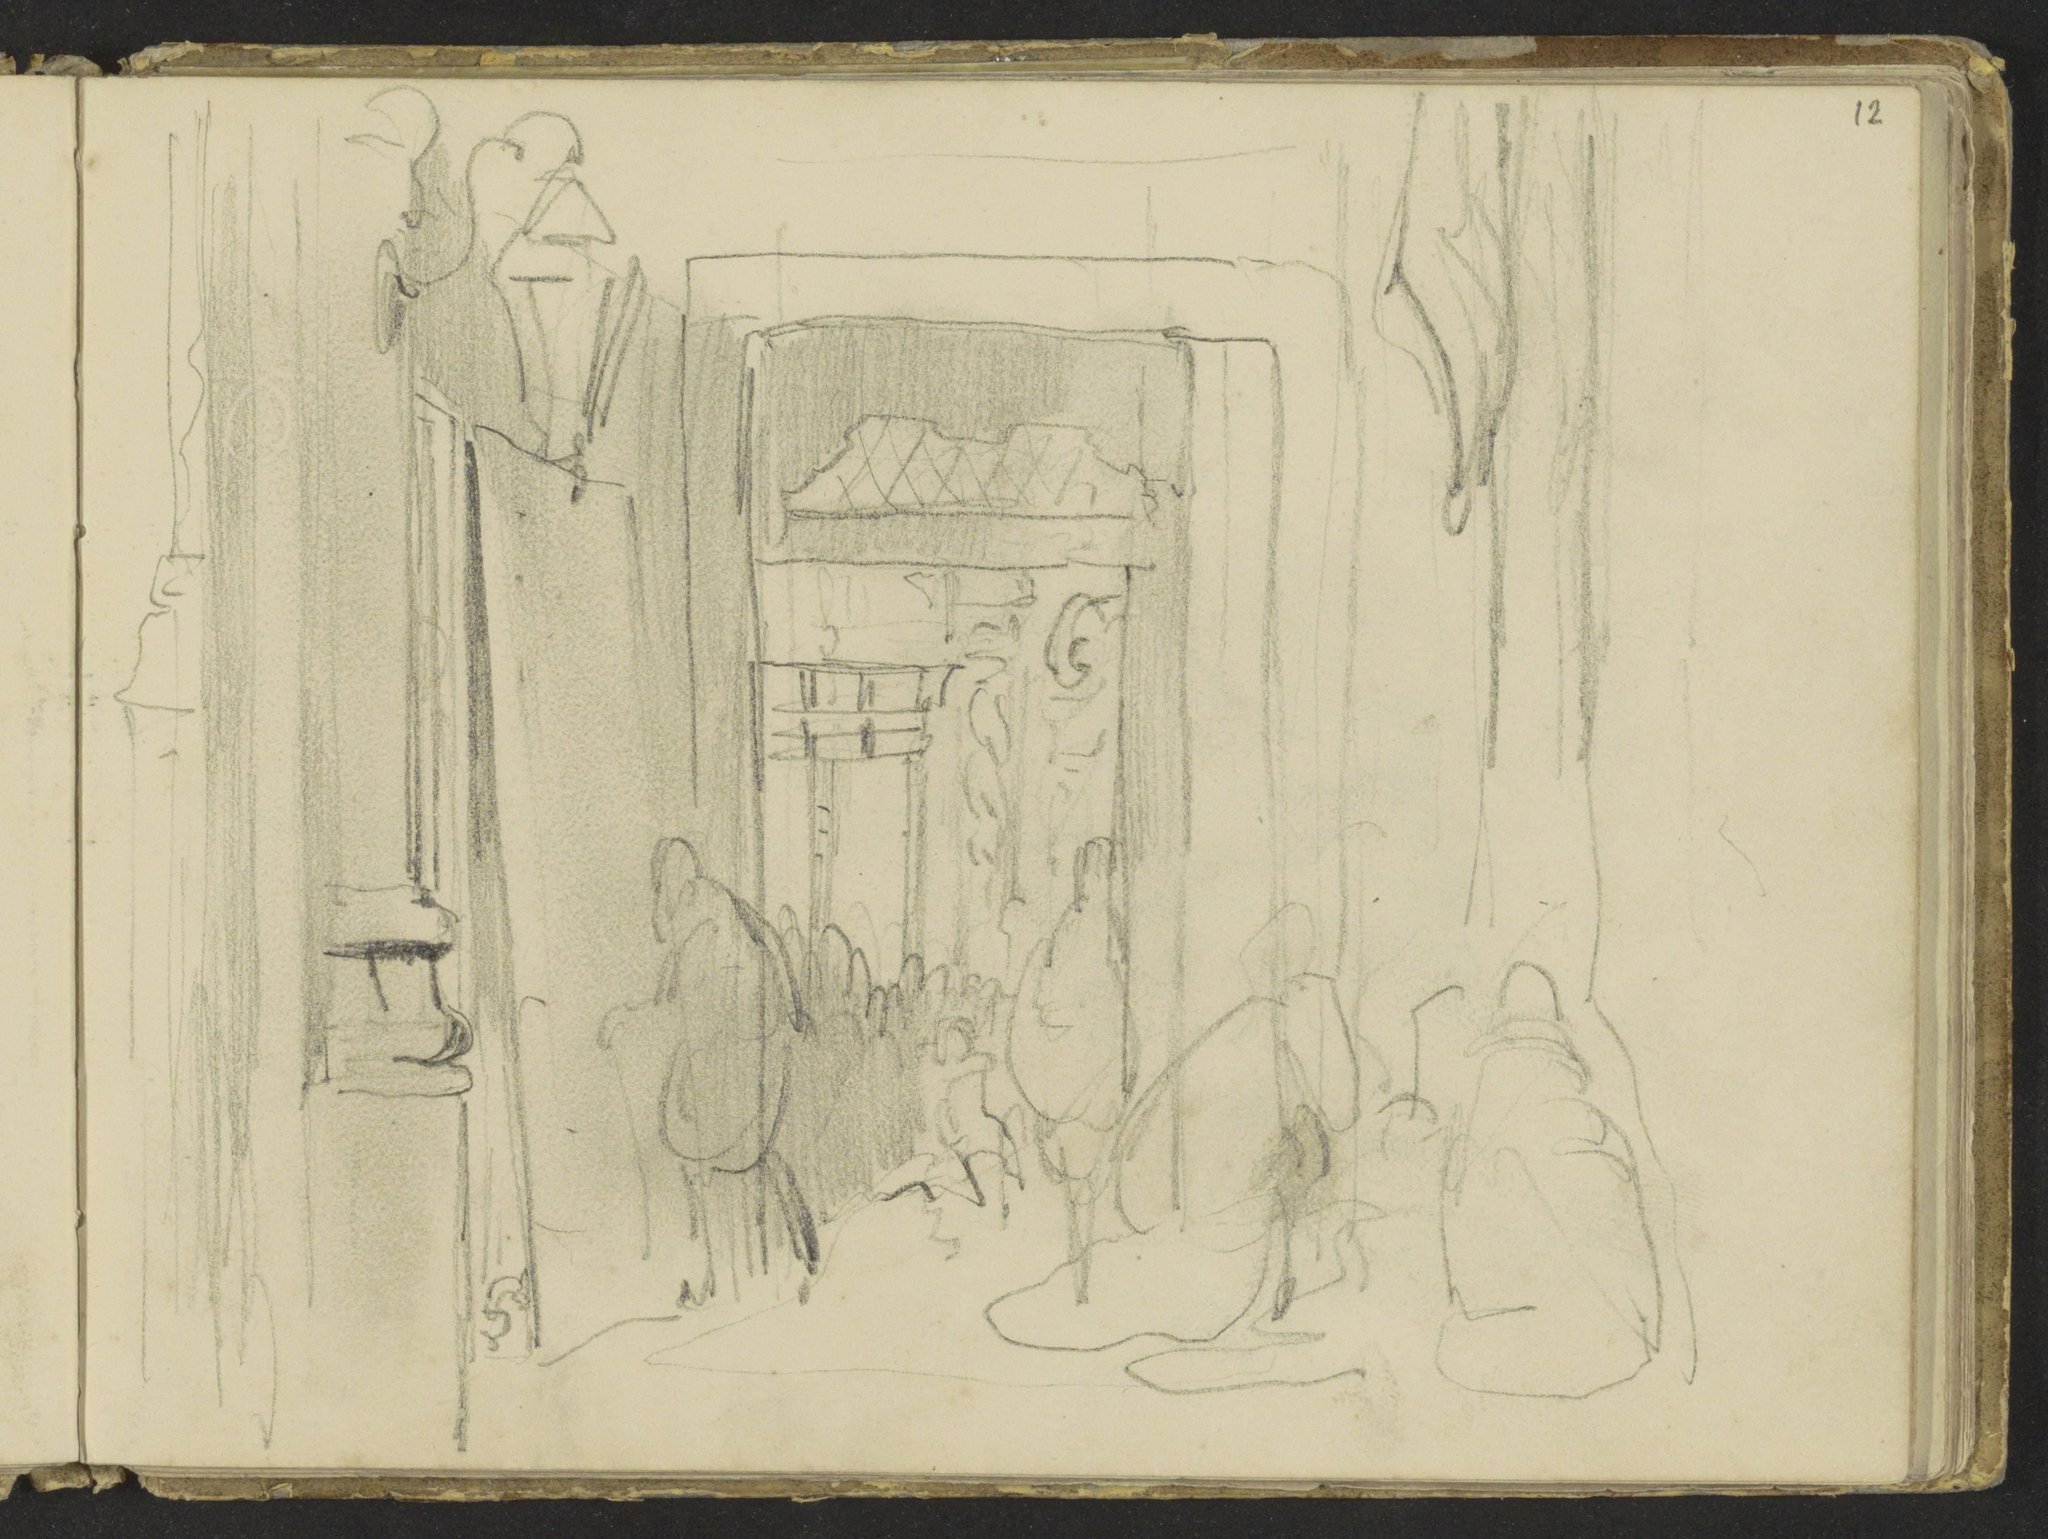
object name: sketchbook leaf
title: Figuren bij een doorgang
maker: willem hendrik schmidt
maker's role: draughtsman, painter, print maker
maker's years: 1809-1849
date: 1819-1849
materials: paper, pencil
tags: vestibule, hall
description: Op de achtergrond is een aansluitende ruimte met figuren te zien. Blad 12 recto uit een schetsboek met 36 bladen.